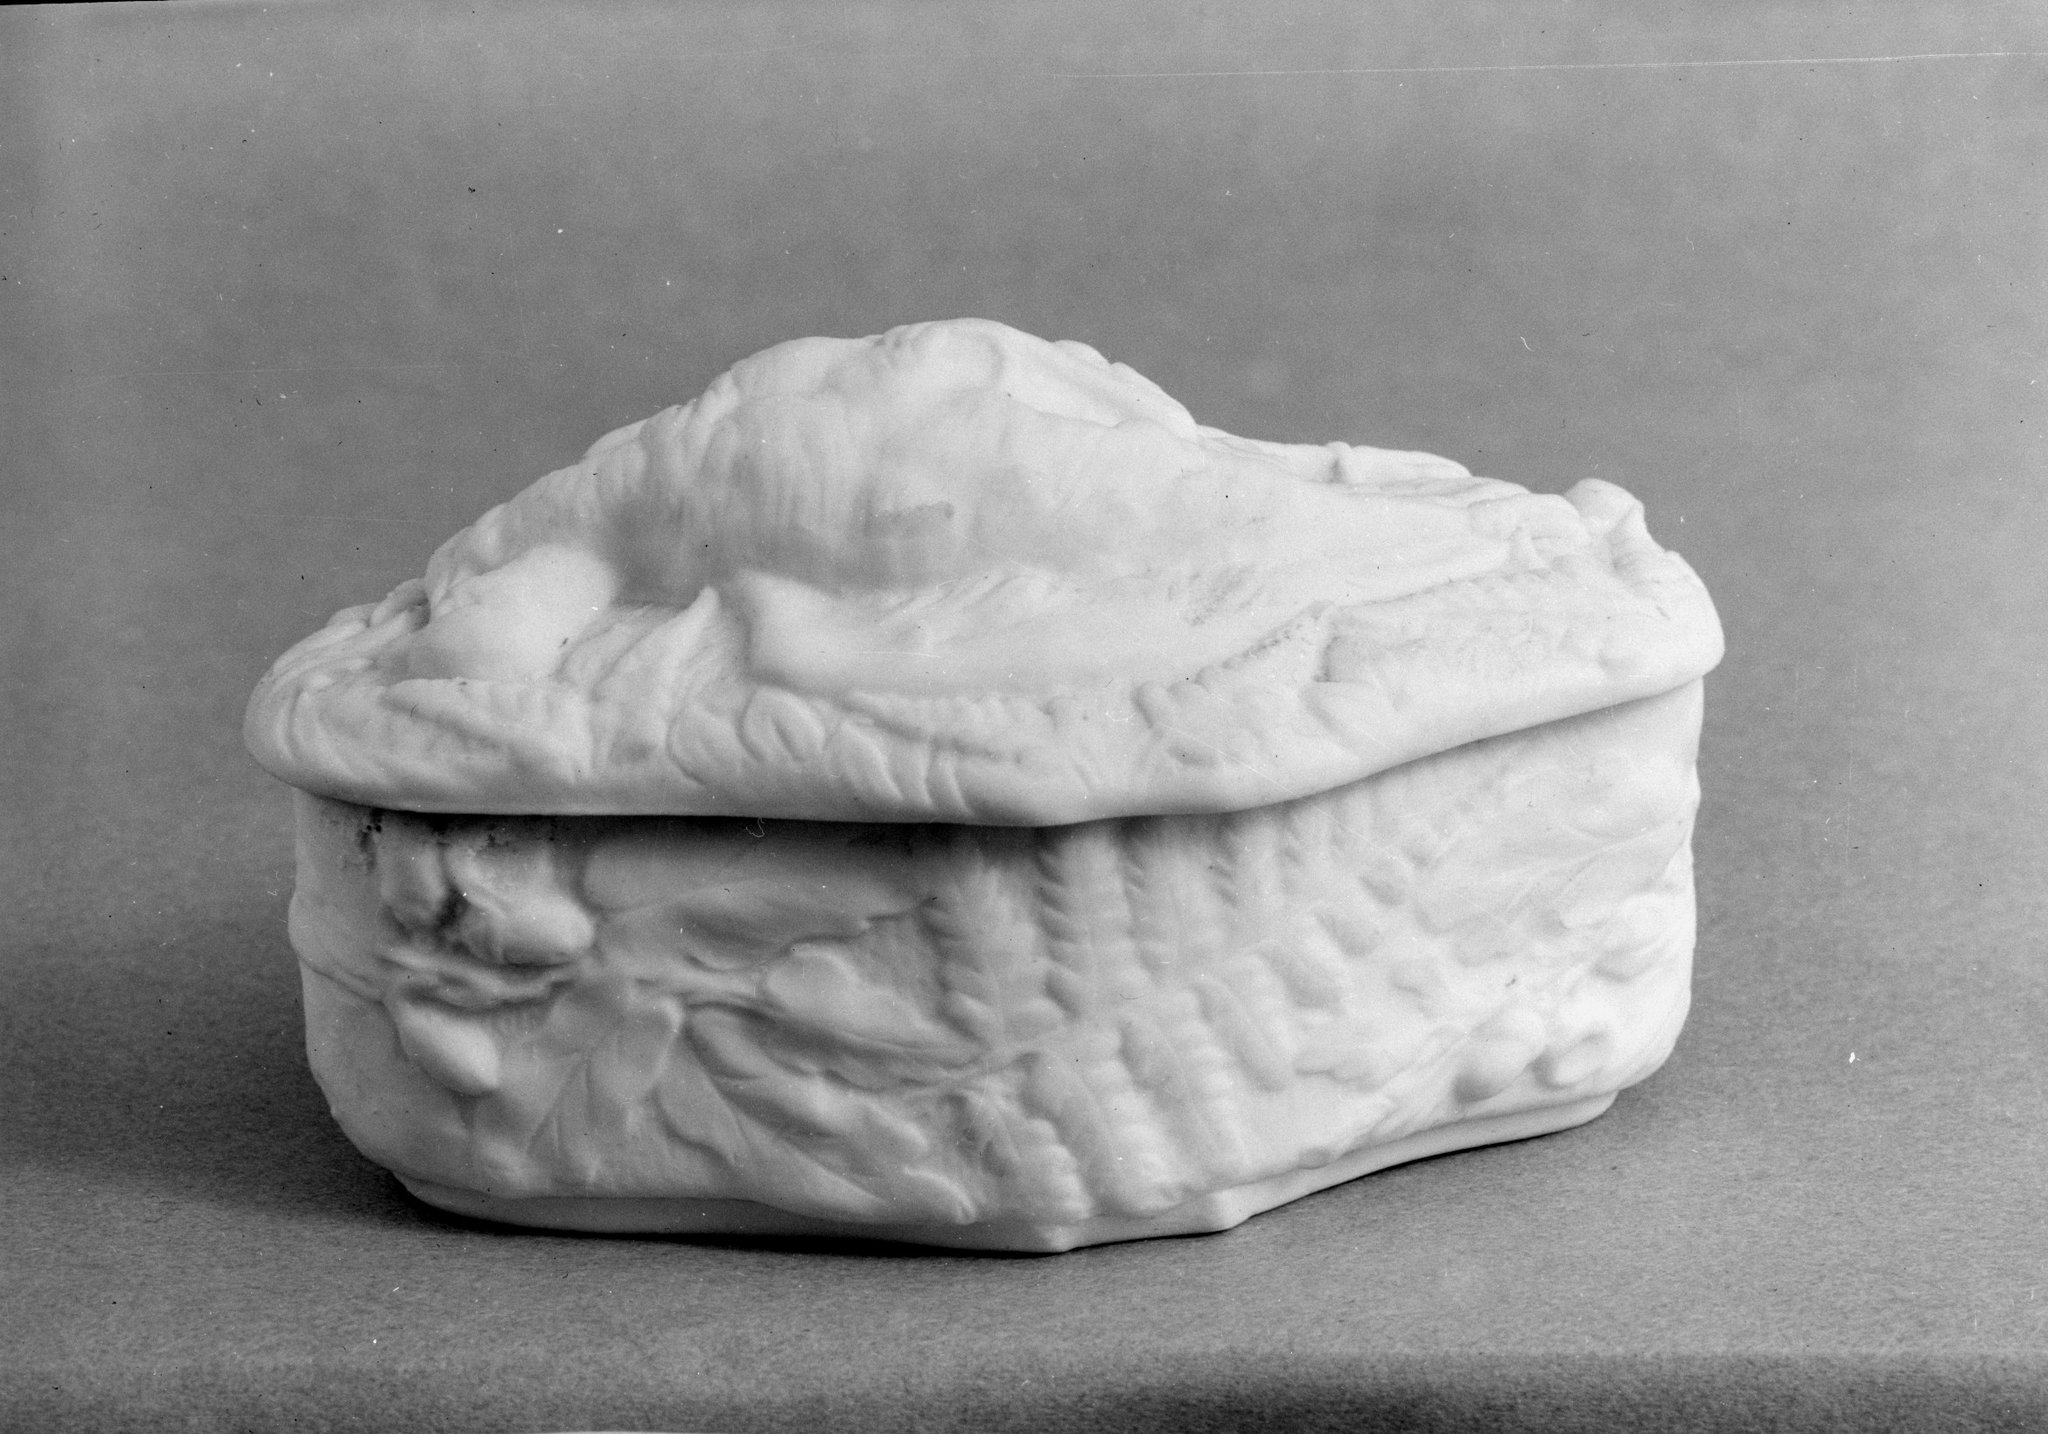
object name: box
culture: american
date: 1830-1870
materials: porcelain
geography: united states